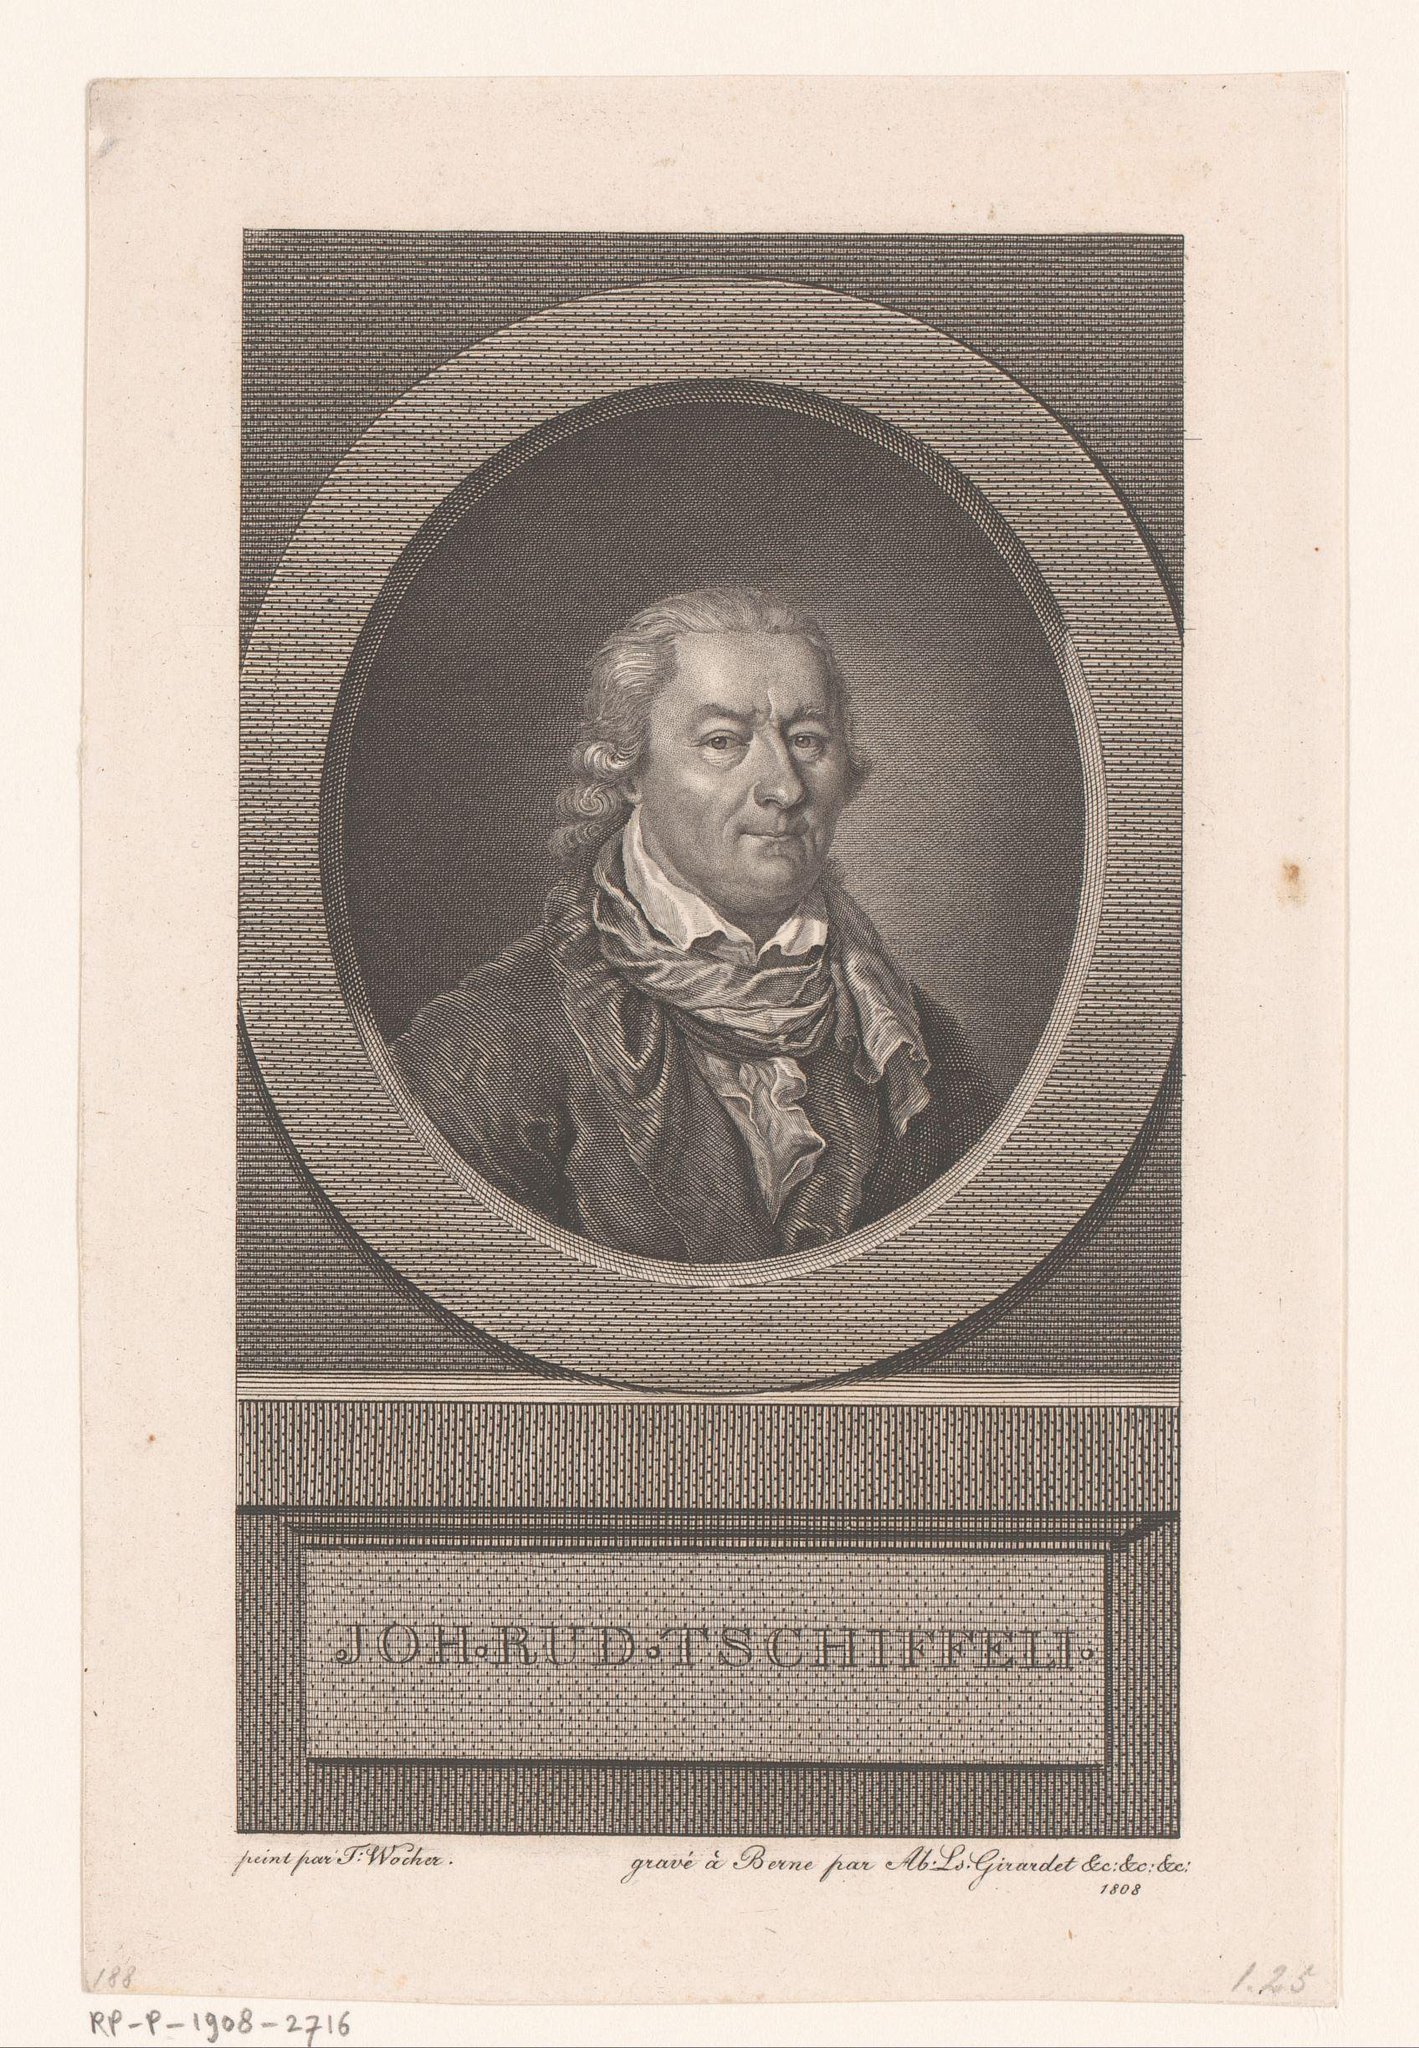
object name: print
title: Portret van Johann Rudolf Tschiffeli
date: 1808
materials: paper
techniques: engraving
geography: bern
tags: historical persons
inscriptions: collector's mark: Lugt 2228